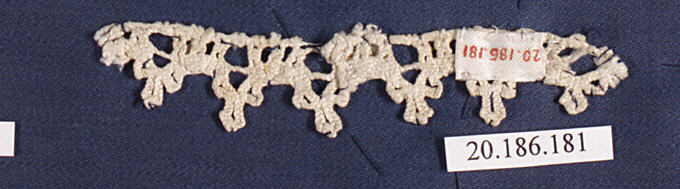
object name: edging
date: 1601-1700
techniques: lace